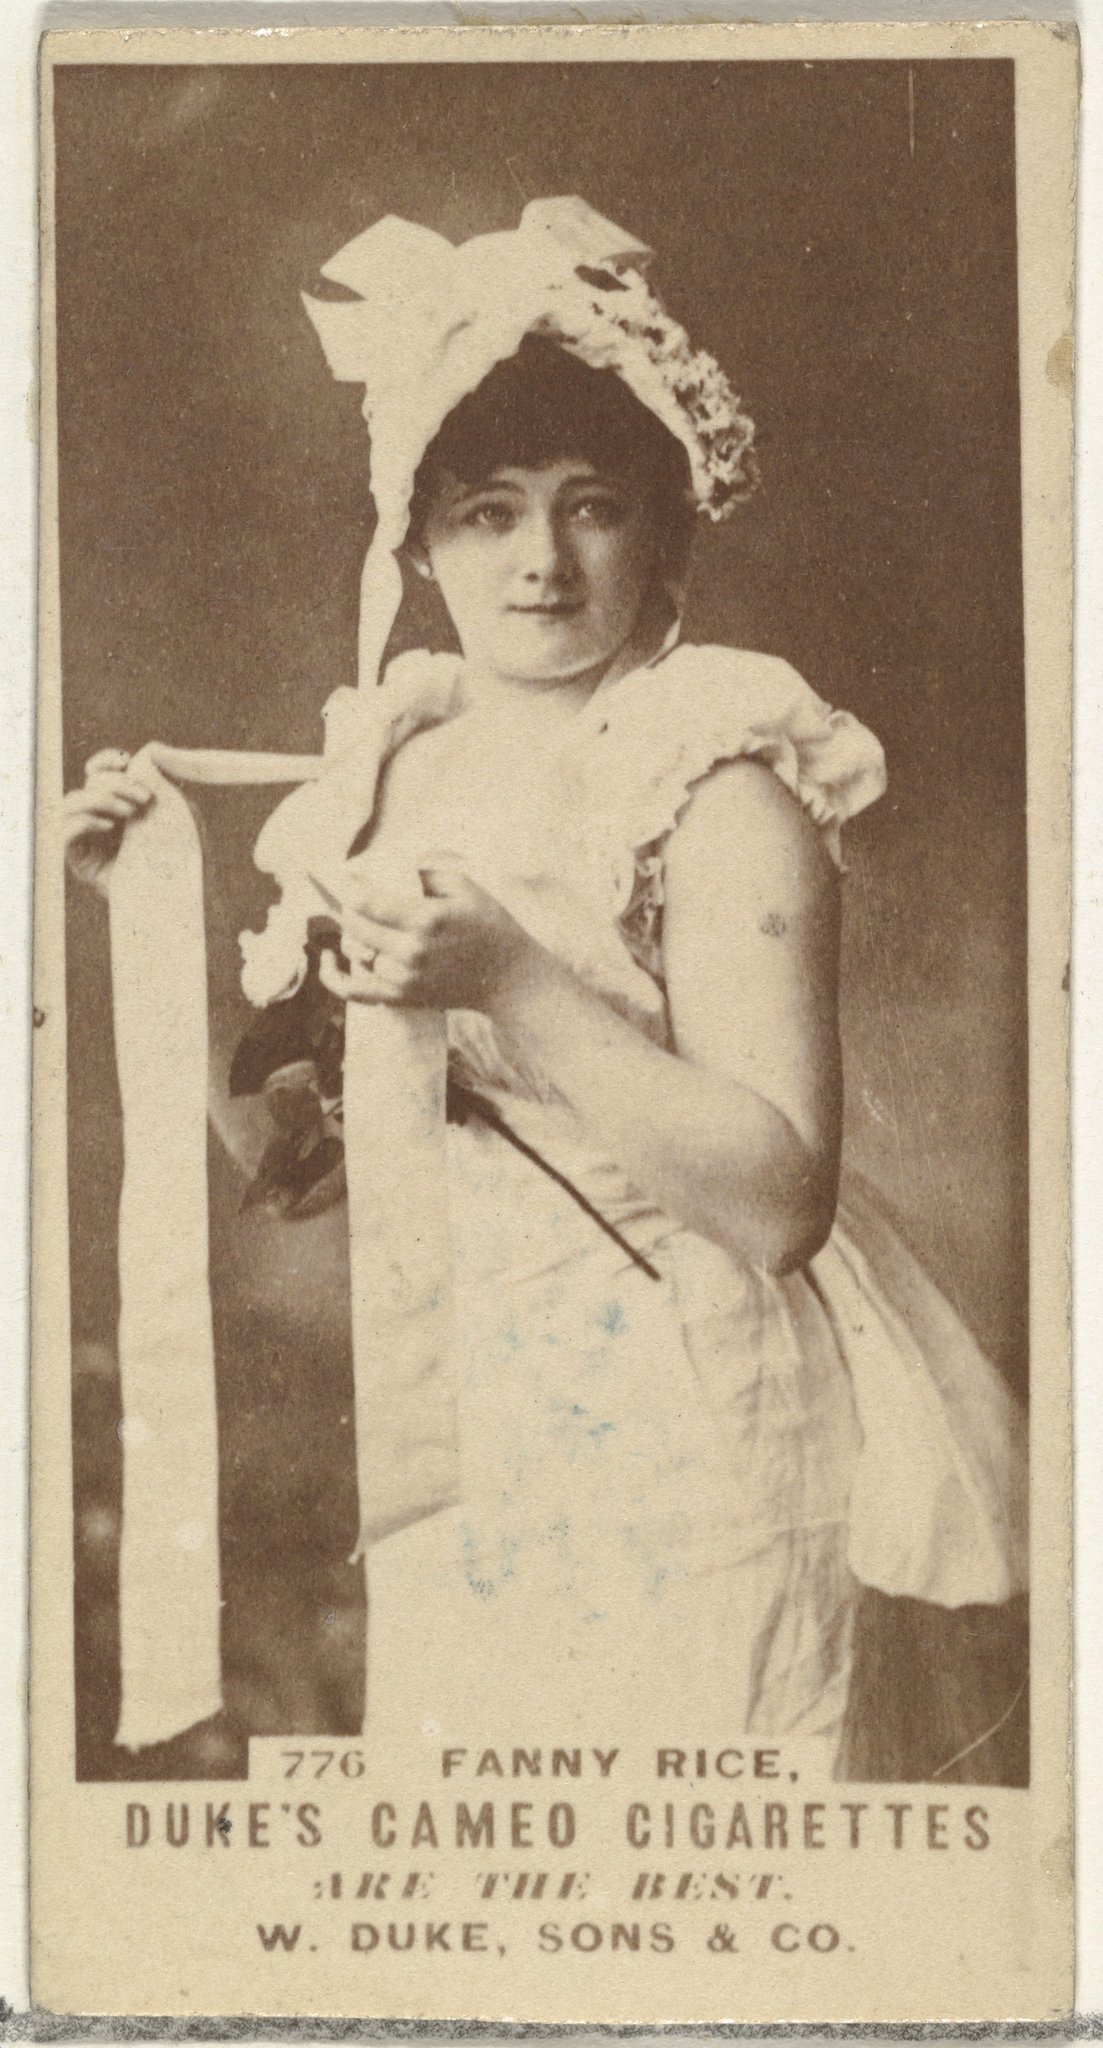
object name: photograph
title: Card Number 776, Fanny Rice, from the Actors and Actresses series (N145-5) issued by Duke Sons & Co. to promote Cameo Cigarettes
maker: w. duke, sons & co.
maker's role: publisher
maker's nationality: american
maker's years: 1870-1920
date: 1880-1889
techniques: albumen silver print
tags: portraits,women,actresses